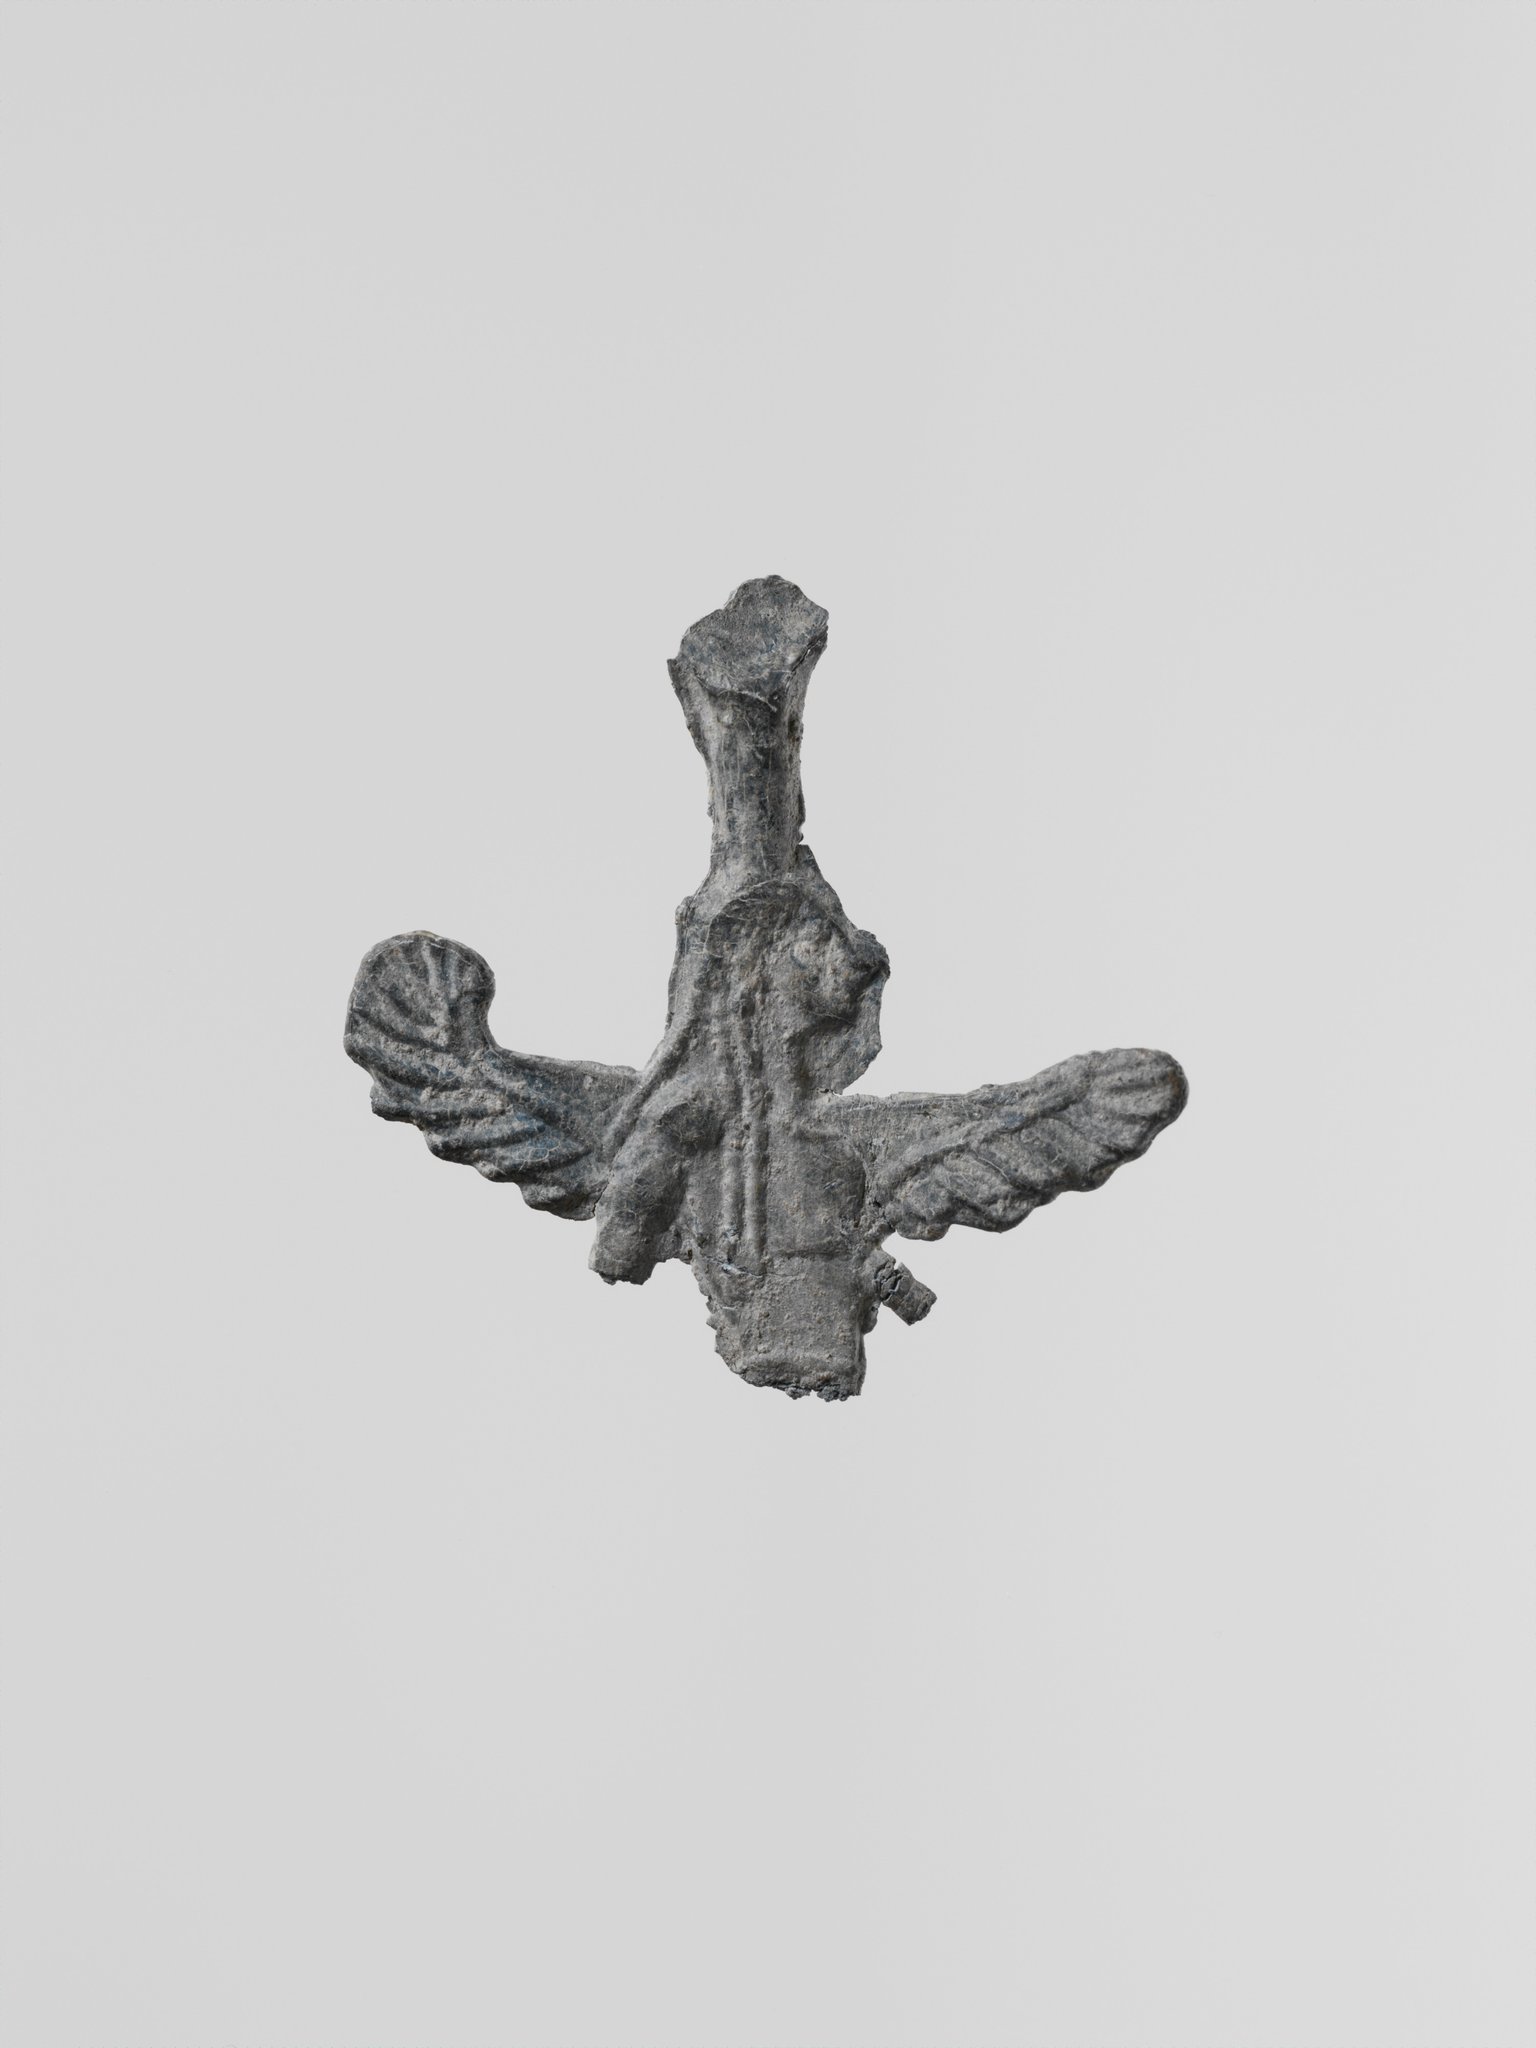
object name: statuette of artemis orthia winged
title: Lead figure of a winged goddess, possibly Artemis Orthia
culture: greek, laconian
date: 634-501 BCE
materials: lead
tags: artemis,goddess